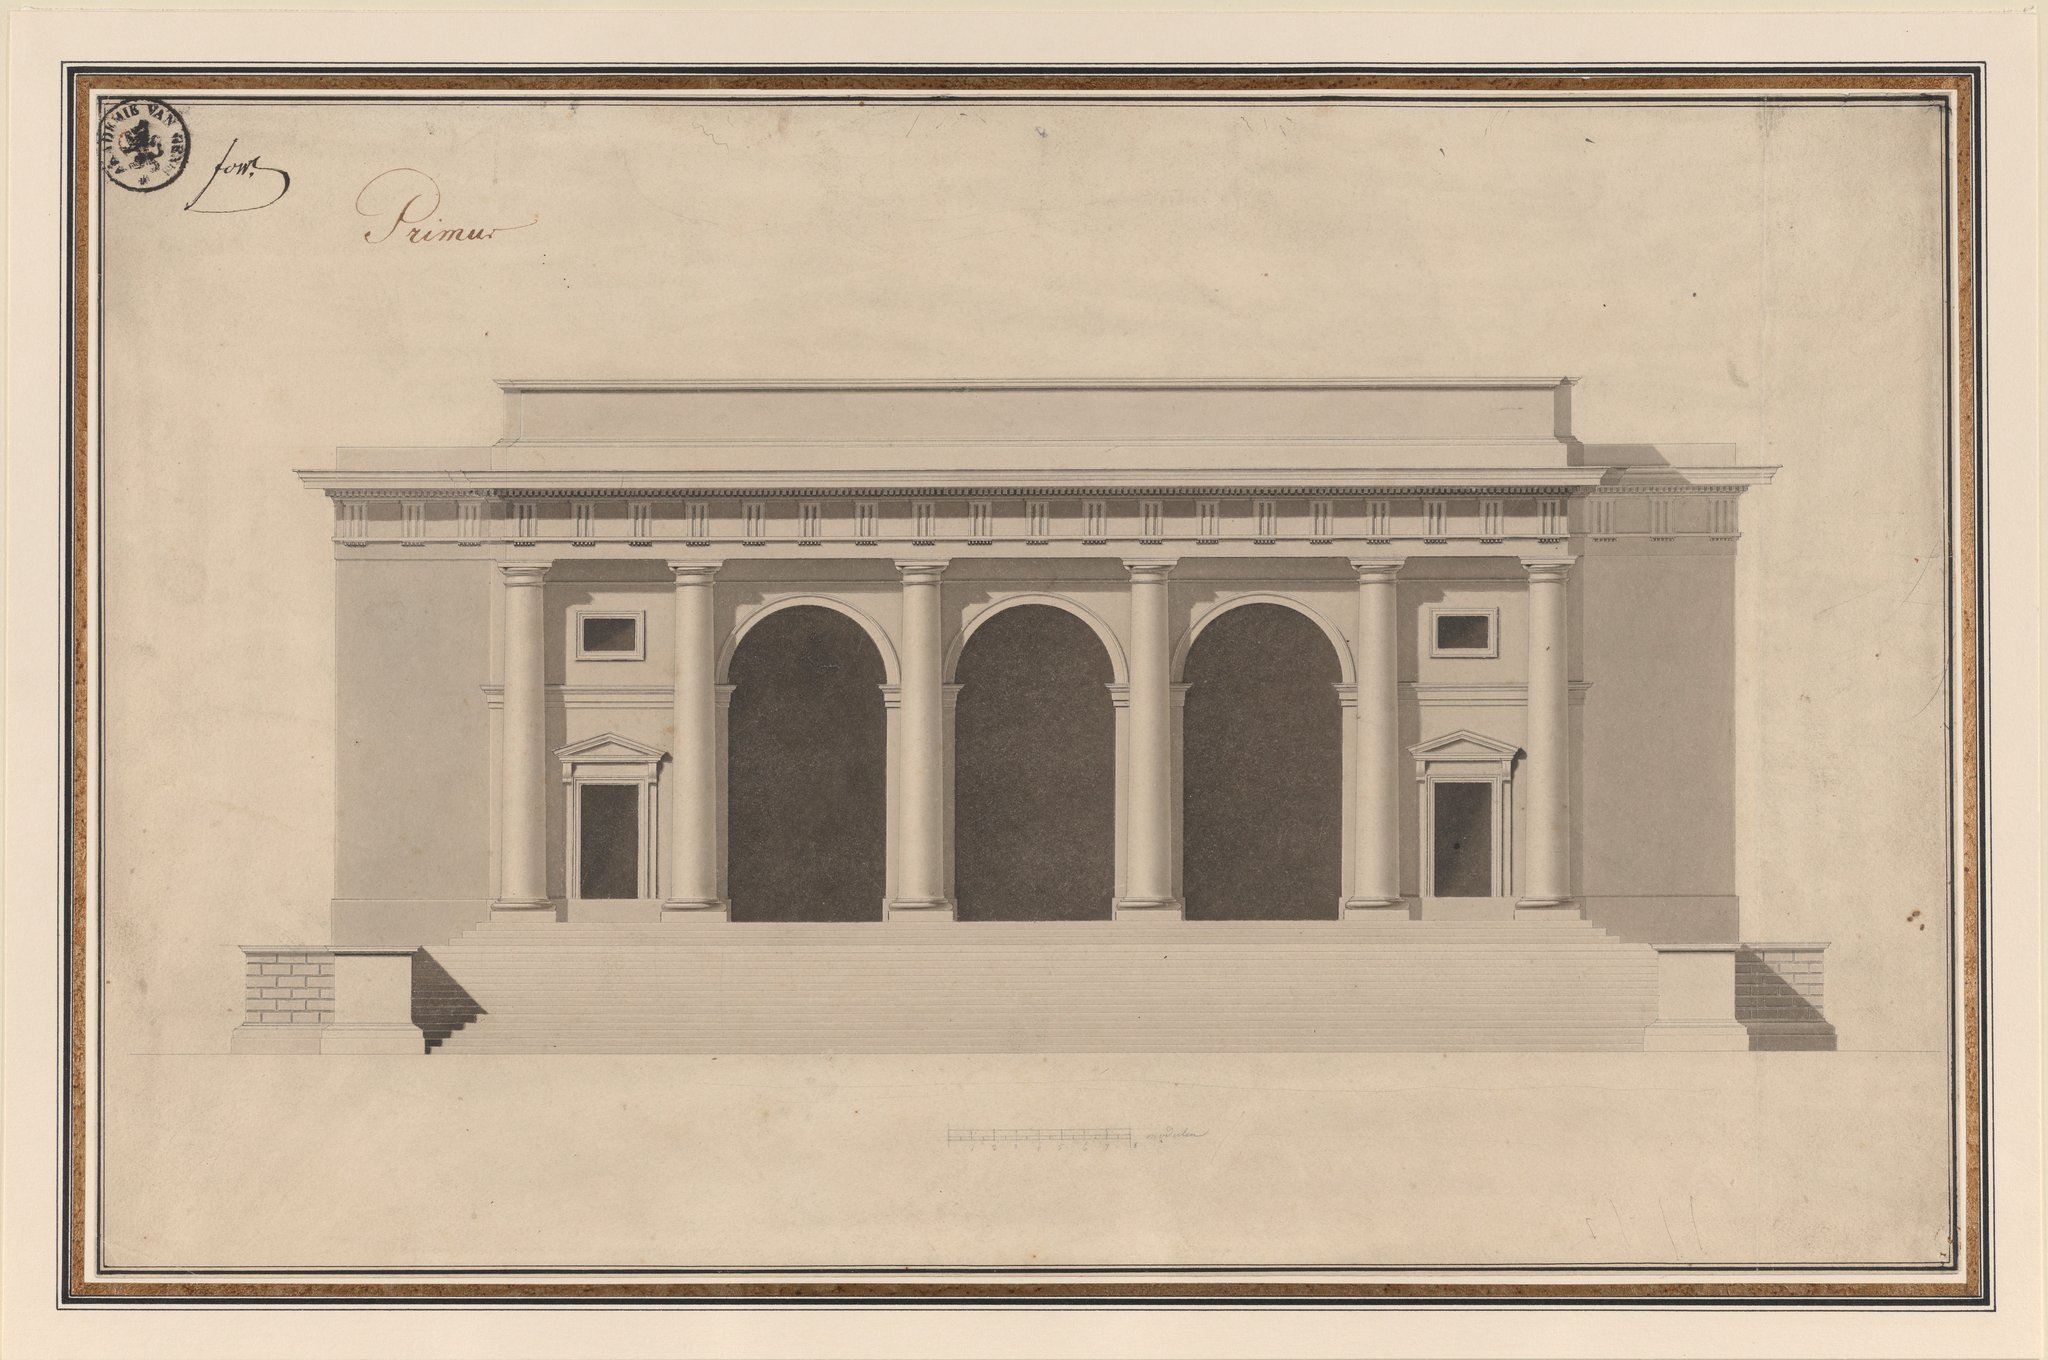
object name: drawing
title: Design for a Façade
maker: anonymous, french, 18th century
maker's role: artist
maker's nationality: french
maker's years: 1700-1800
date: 1734-1766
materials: ink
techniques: brush, pen, wash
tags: architecture,buildings